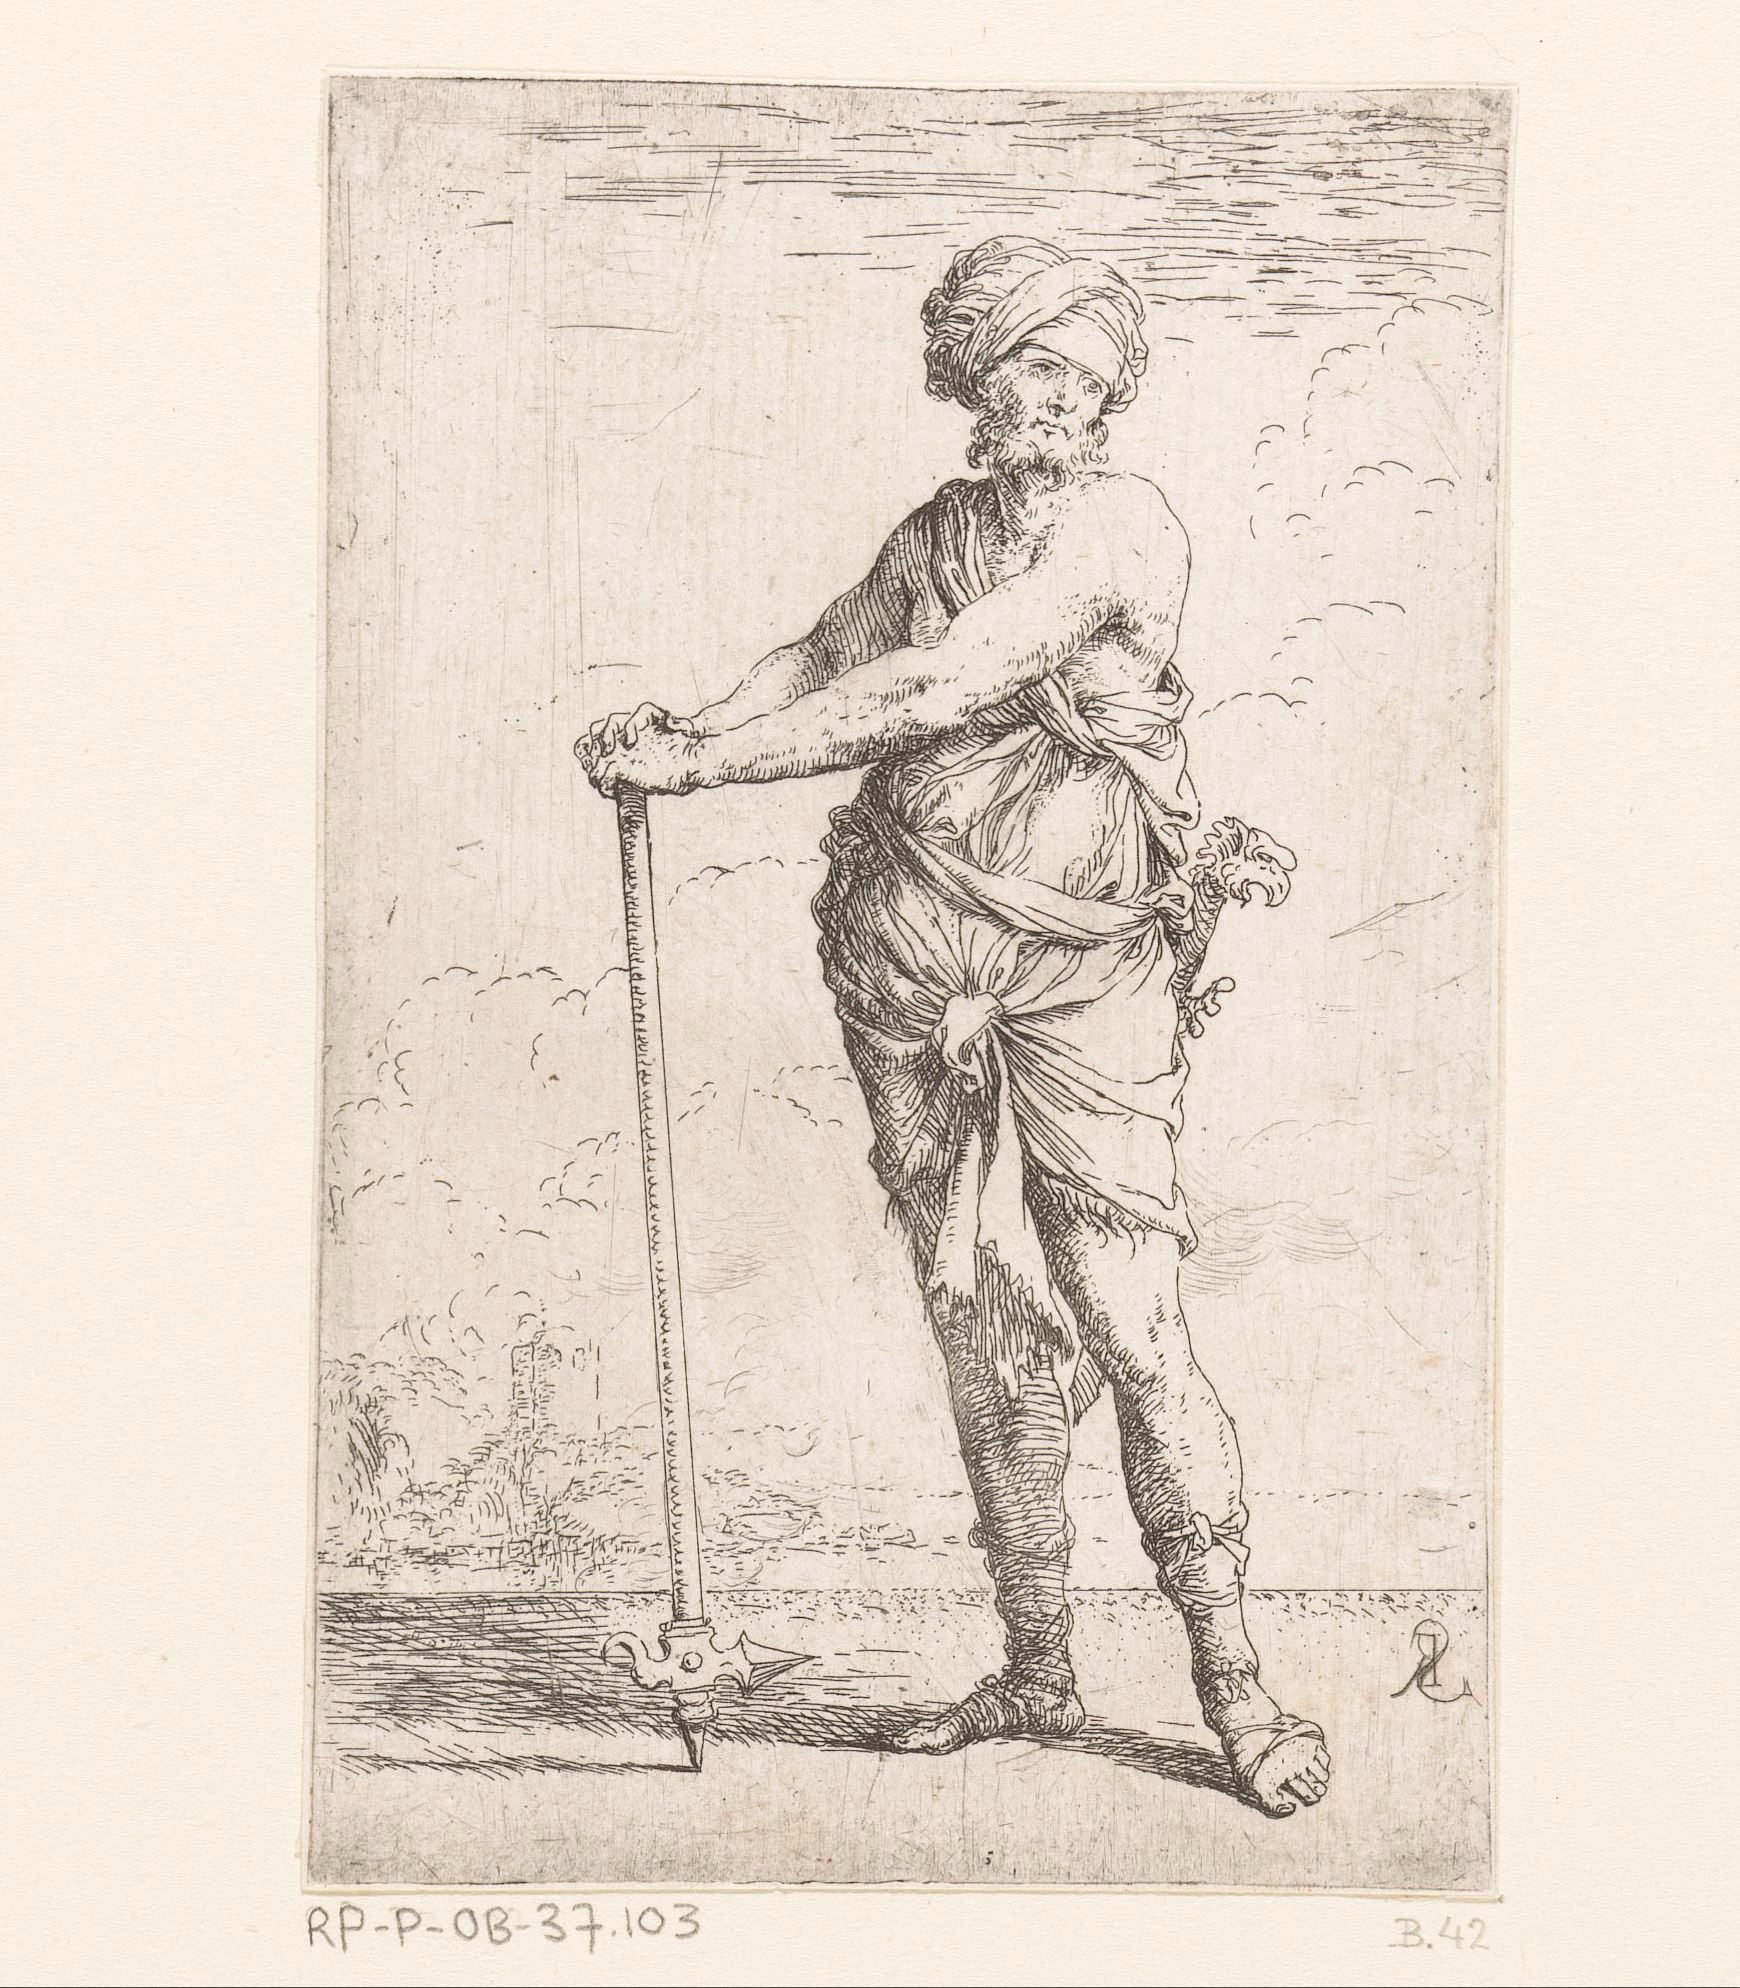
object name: print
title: Figurine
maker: salvator rosa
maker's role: draughtsman, painter, print maker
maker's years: 1615-1673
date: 1656-1657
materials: paper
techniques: drypoint, etching, intaglio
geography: italy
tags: head-gear, the soldier; the soldier's life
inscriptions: collector's mark: Lugt 240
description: Prent spiegelbeeldig naar een tekening in het Metropolitan Museum of Art te New York (inv.nr. 1970.101.12). Deze prent maakt deel uit van de serie 'Figurine', bestaande uit een titelprent en 80 prenten van klein formaat met voorstellingen van mannelijke en vrouwelijke figuren. Rosa produceerde de serie waarschijnlijk gedurende de jaren 1656 en 1657.